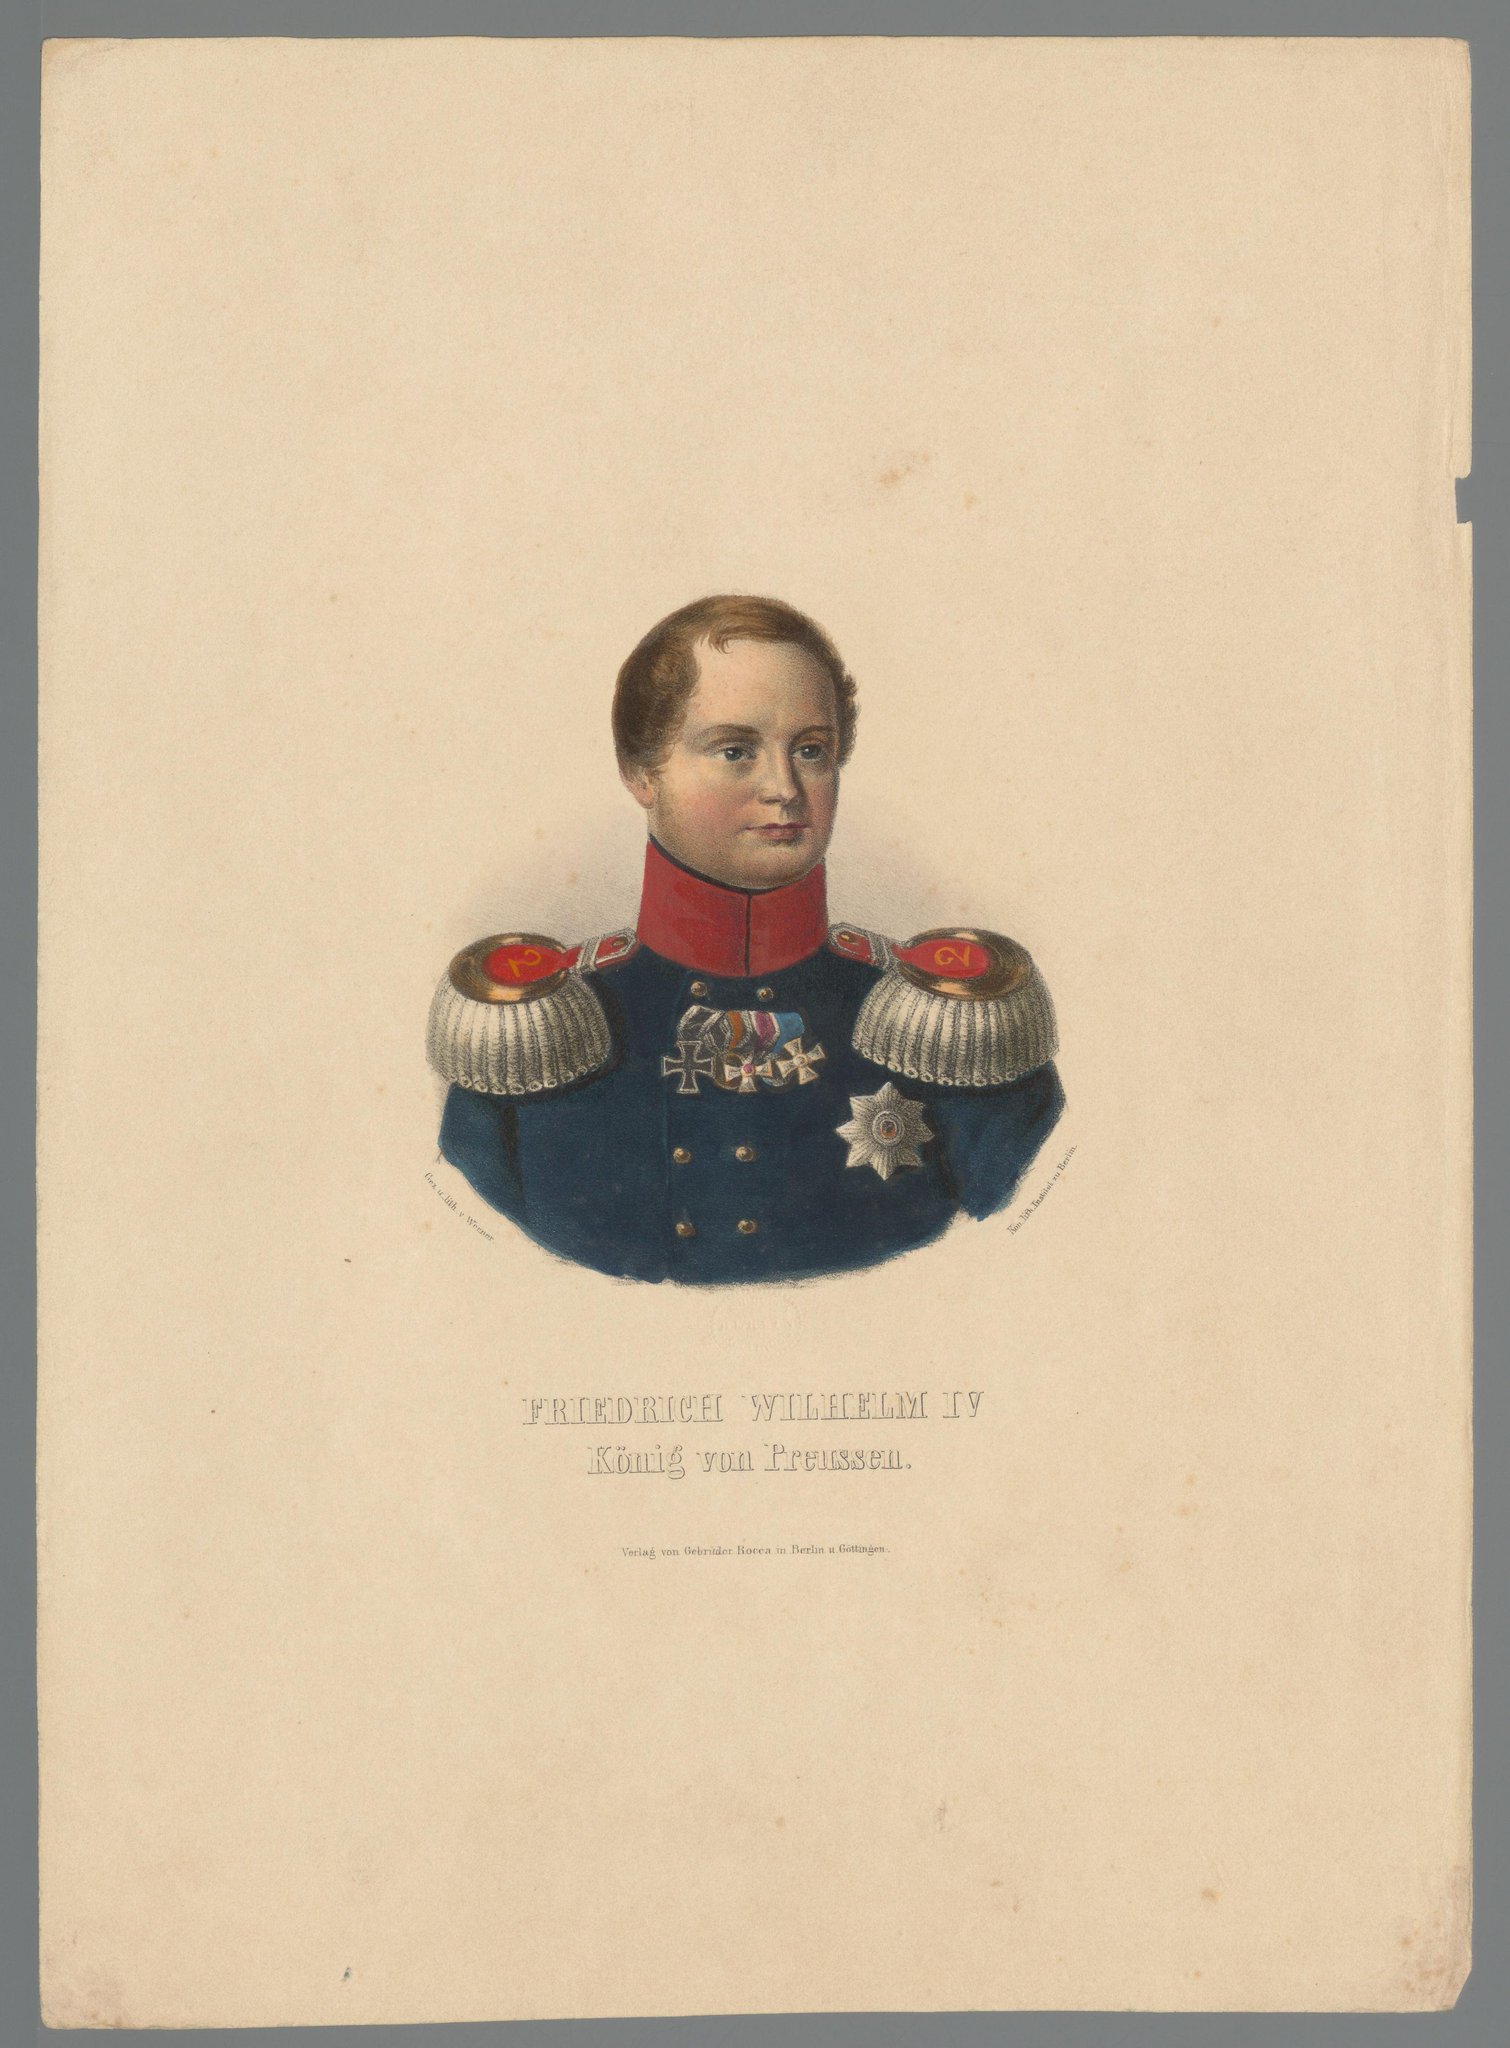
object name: print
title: Friedrich Wilhelm IV, König von Preussen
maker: werner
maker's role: print maker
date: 1830-1863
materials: paper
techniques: hand coloring, lithograph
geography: berlin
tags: berlin, frederik willem iv (koning van pruisen), adult man, historical persons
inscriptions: collector's mark: Lugt 2228, check stamp: Lugt 5514